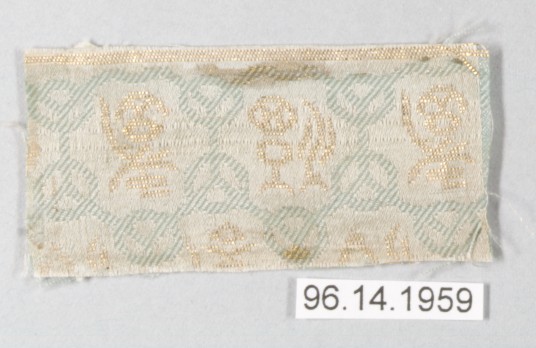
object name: piece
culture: japanese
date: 1701-1900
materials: silk